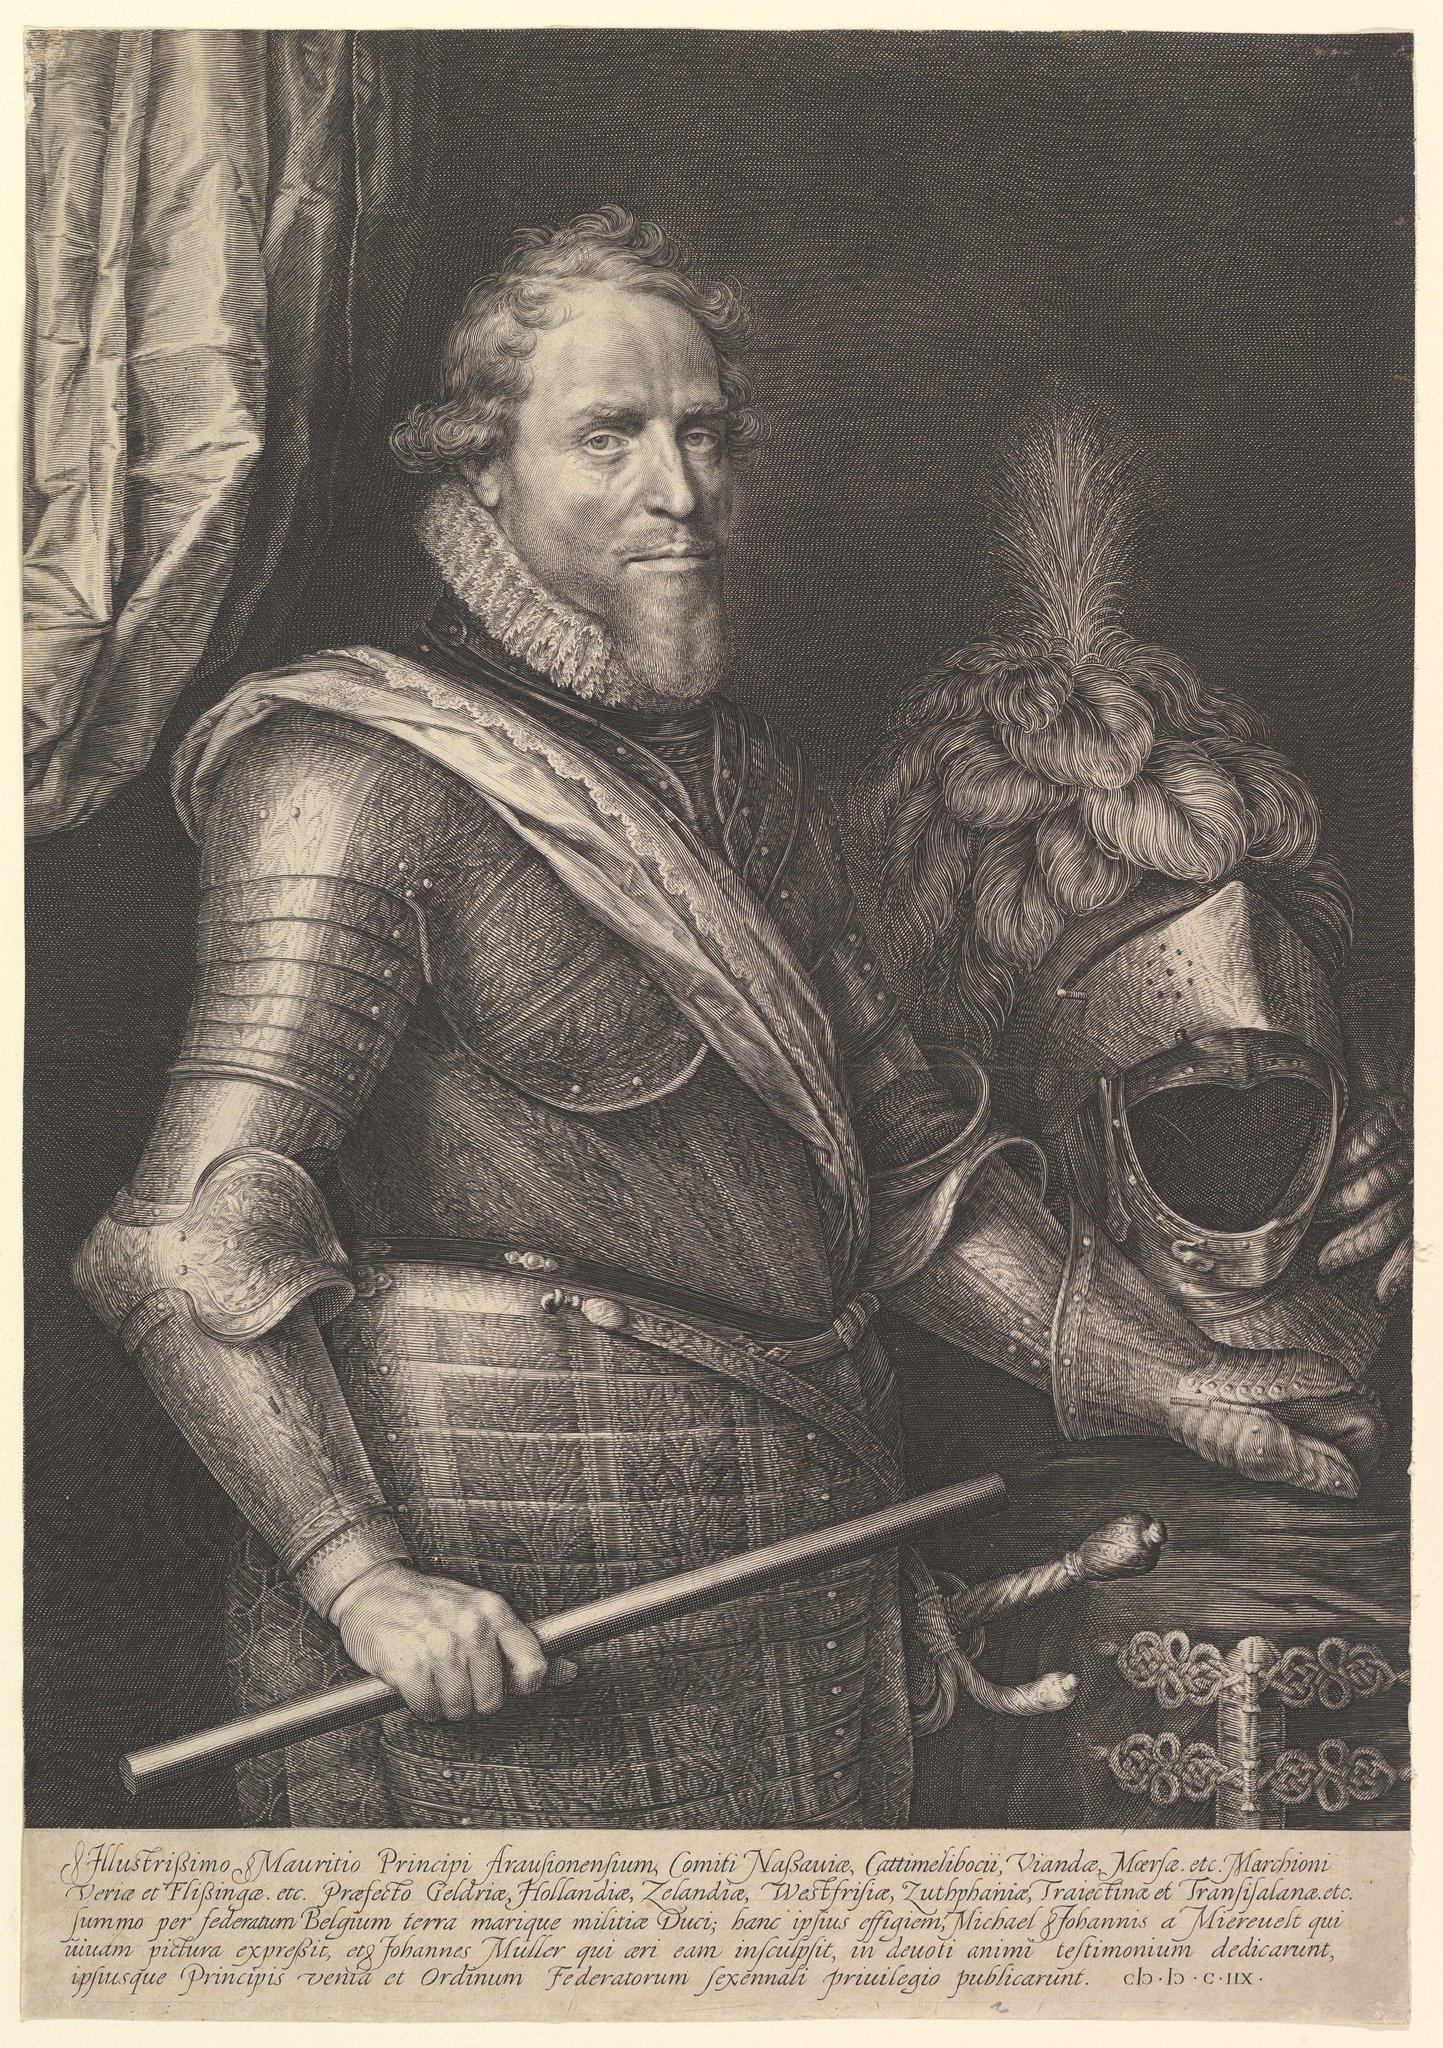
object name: print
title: Portrait of Maurits, Prince of Orange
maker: jan muller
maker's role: artist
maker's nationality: netherlandish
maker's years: 1571-1628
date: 1608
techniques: engraving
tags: armor,helmets,princes